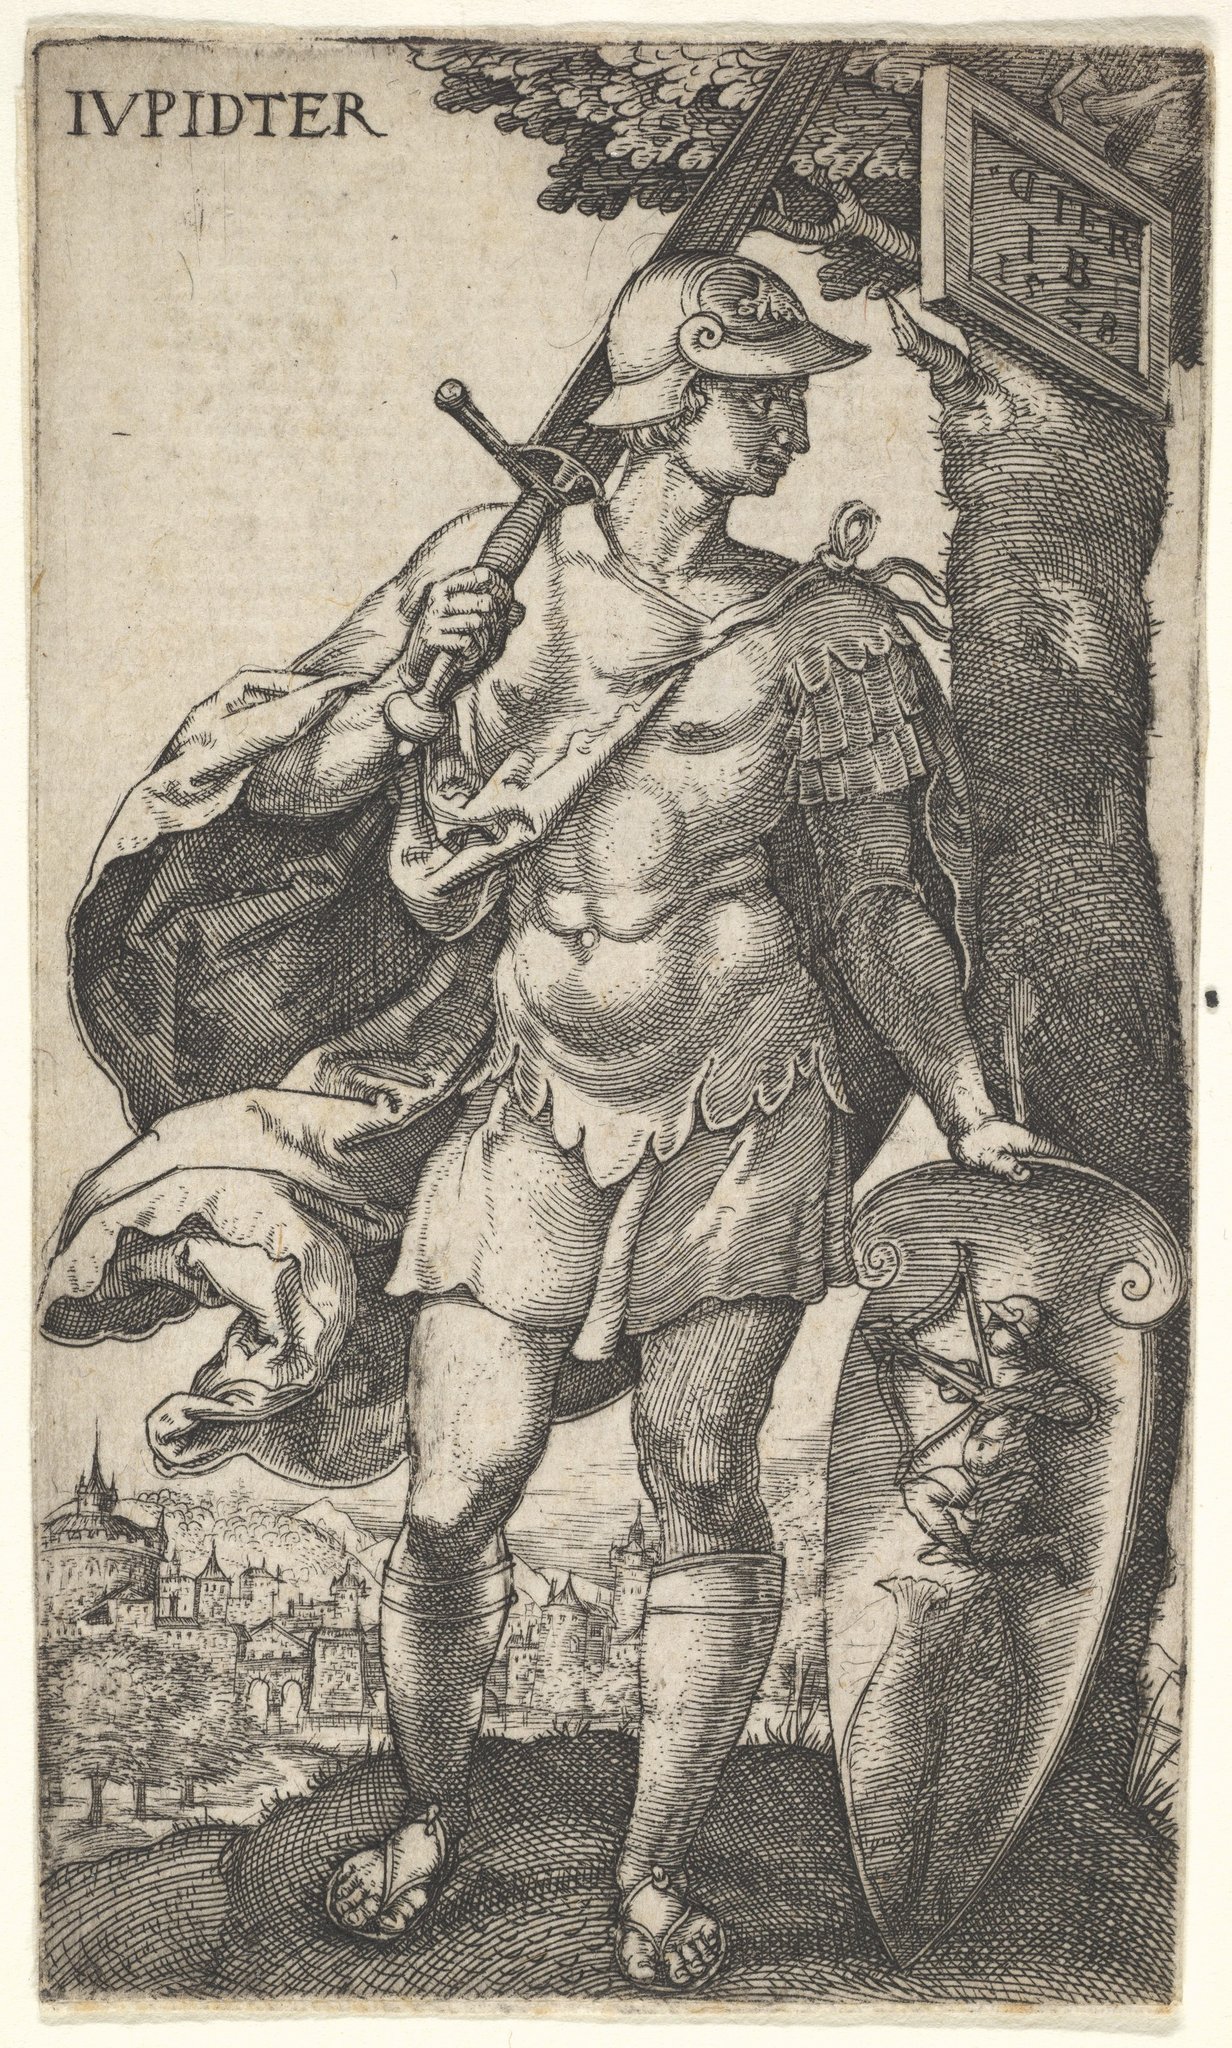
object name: print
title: Jupiter, from "The Gods Who Preside Over the Planets"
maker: master i.b.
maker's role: artist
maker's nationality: german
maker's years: 1525-1530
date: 1528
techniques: etching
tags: shields,swords,jupiter